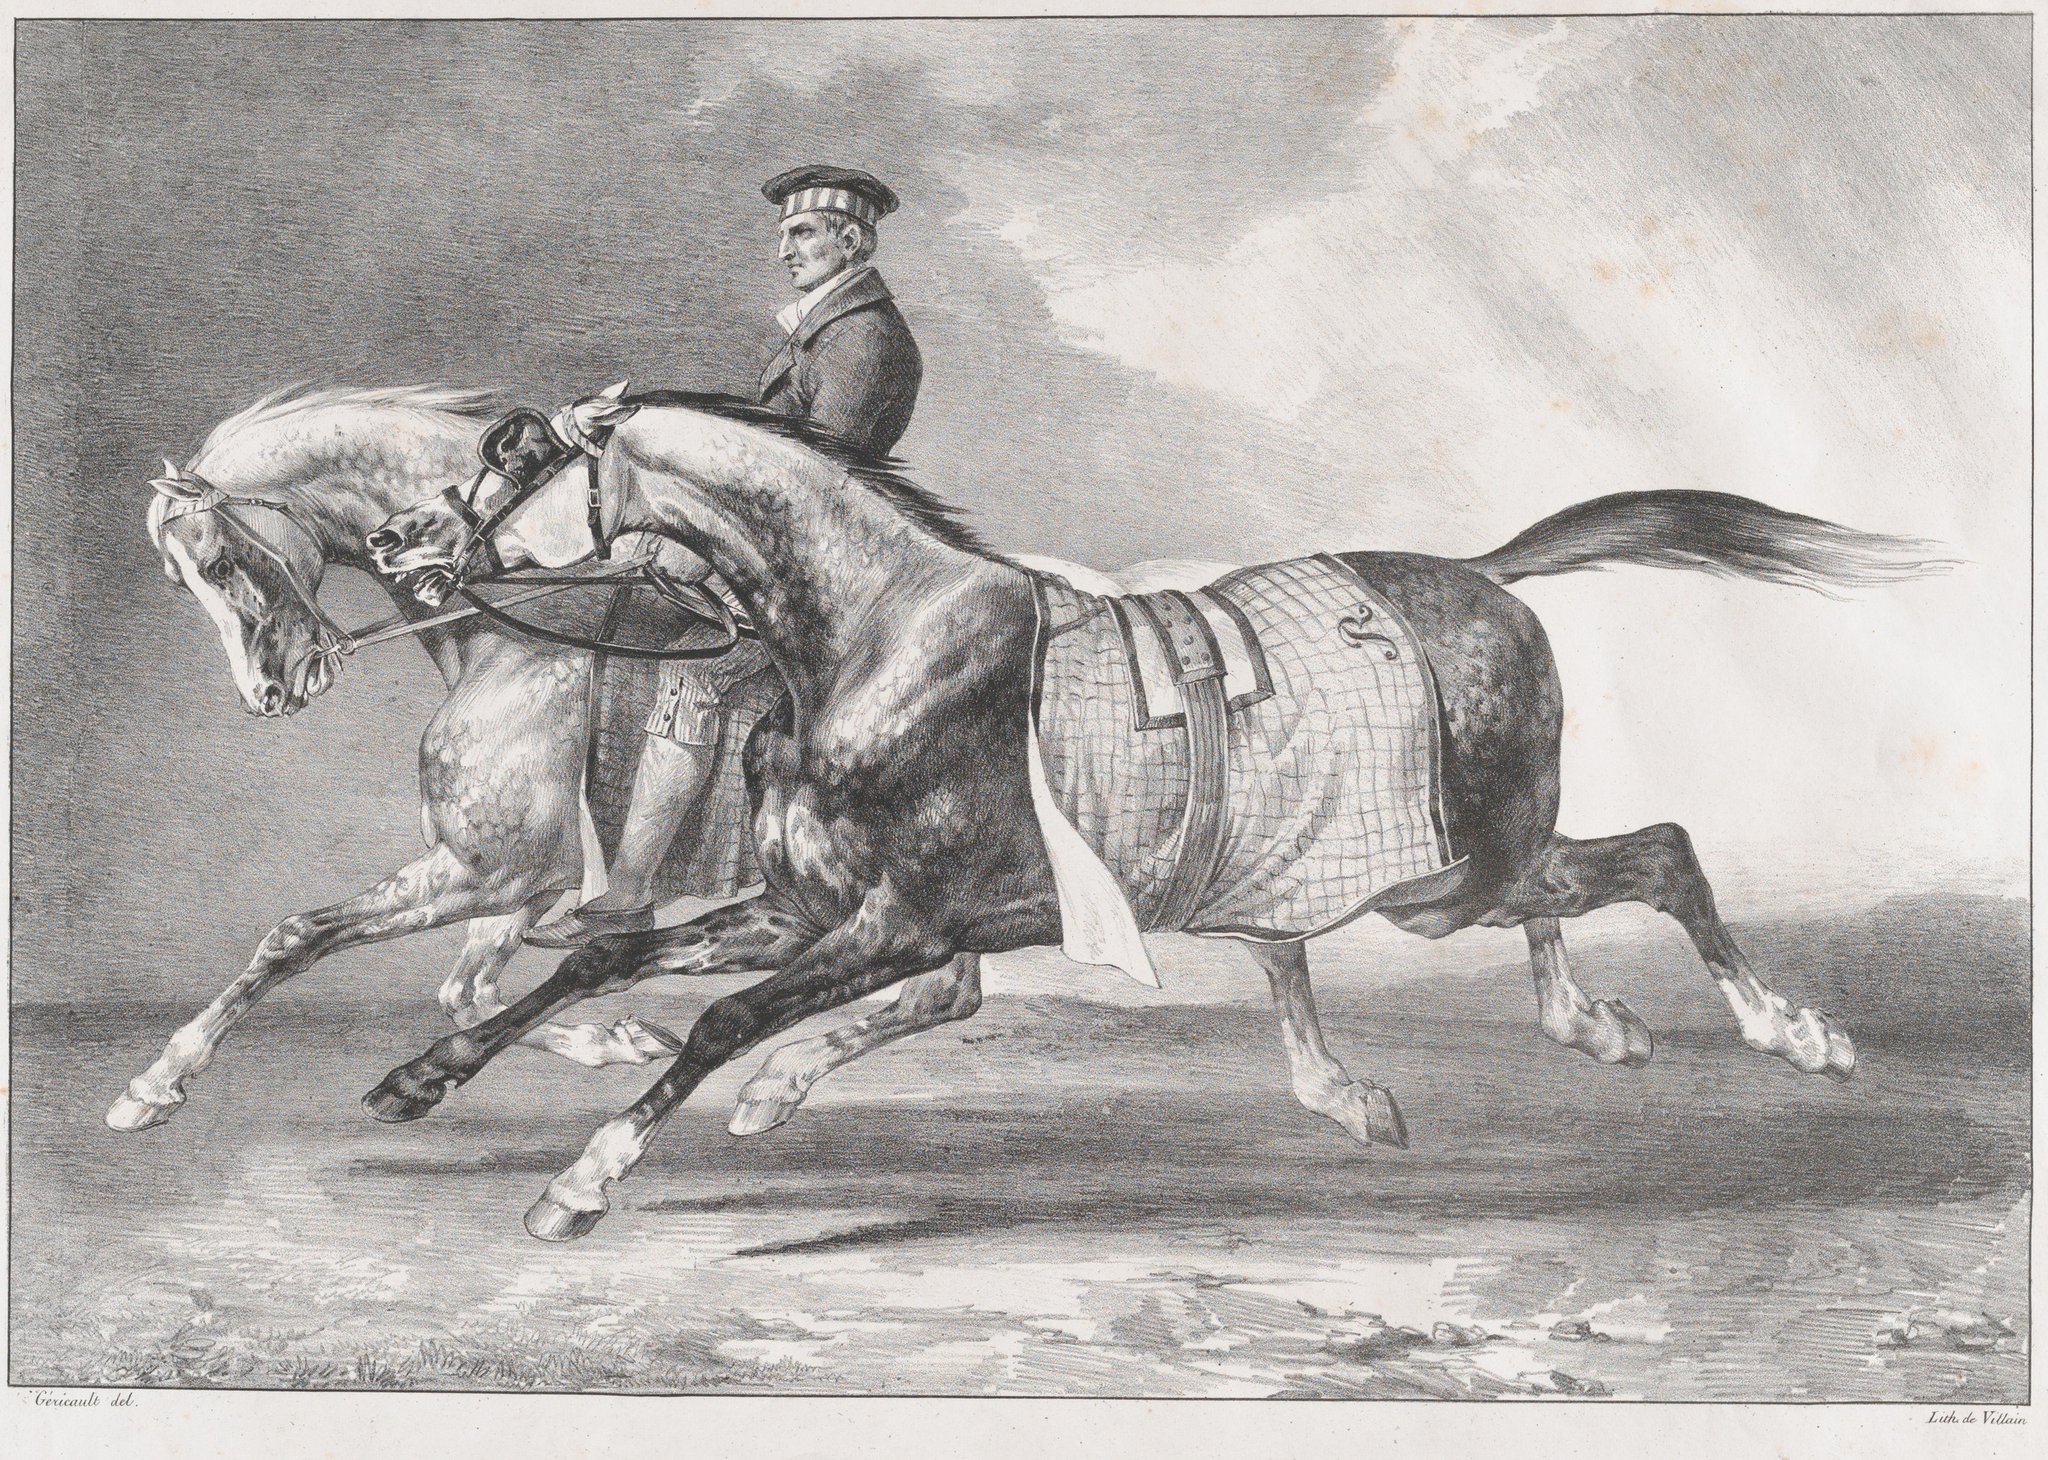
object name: print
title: Two Dappled-Grey Horses Being Exercised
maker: jean louis andré théodore géricault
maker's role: artist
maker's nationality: french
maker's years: 1791-1824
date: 1822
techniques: lithograph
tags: men,horses